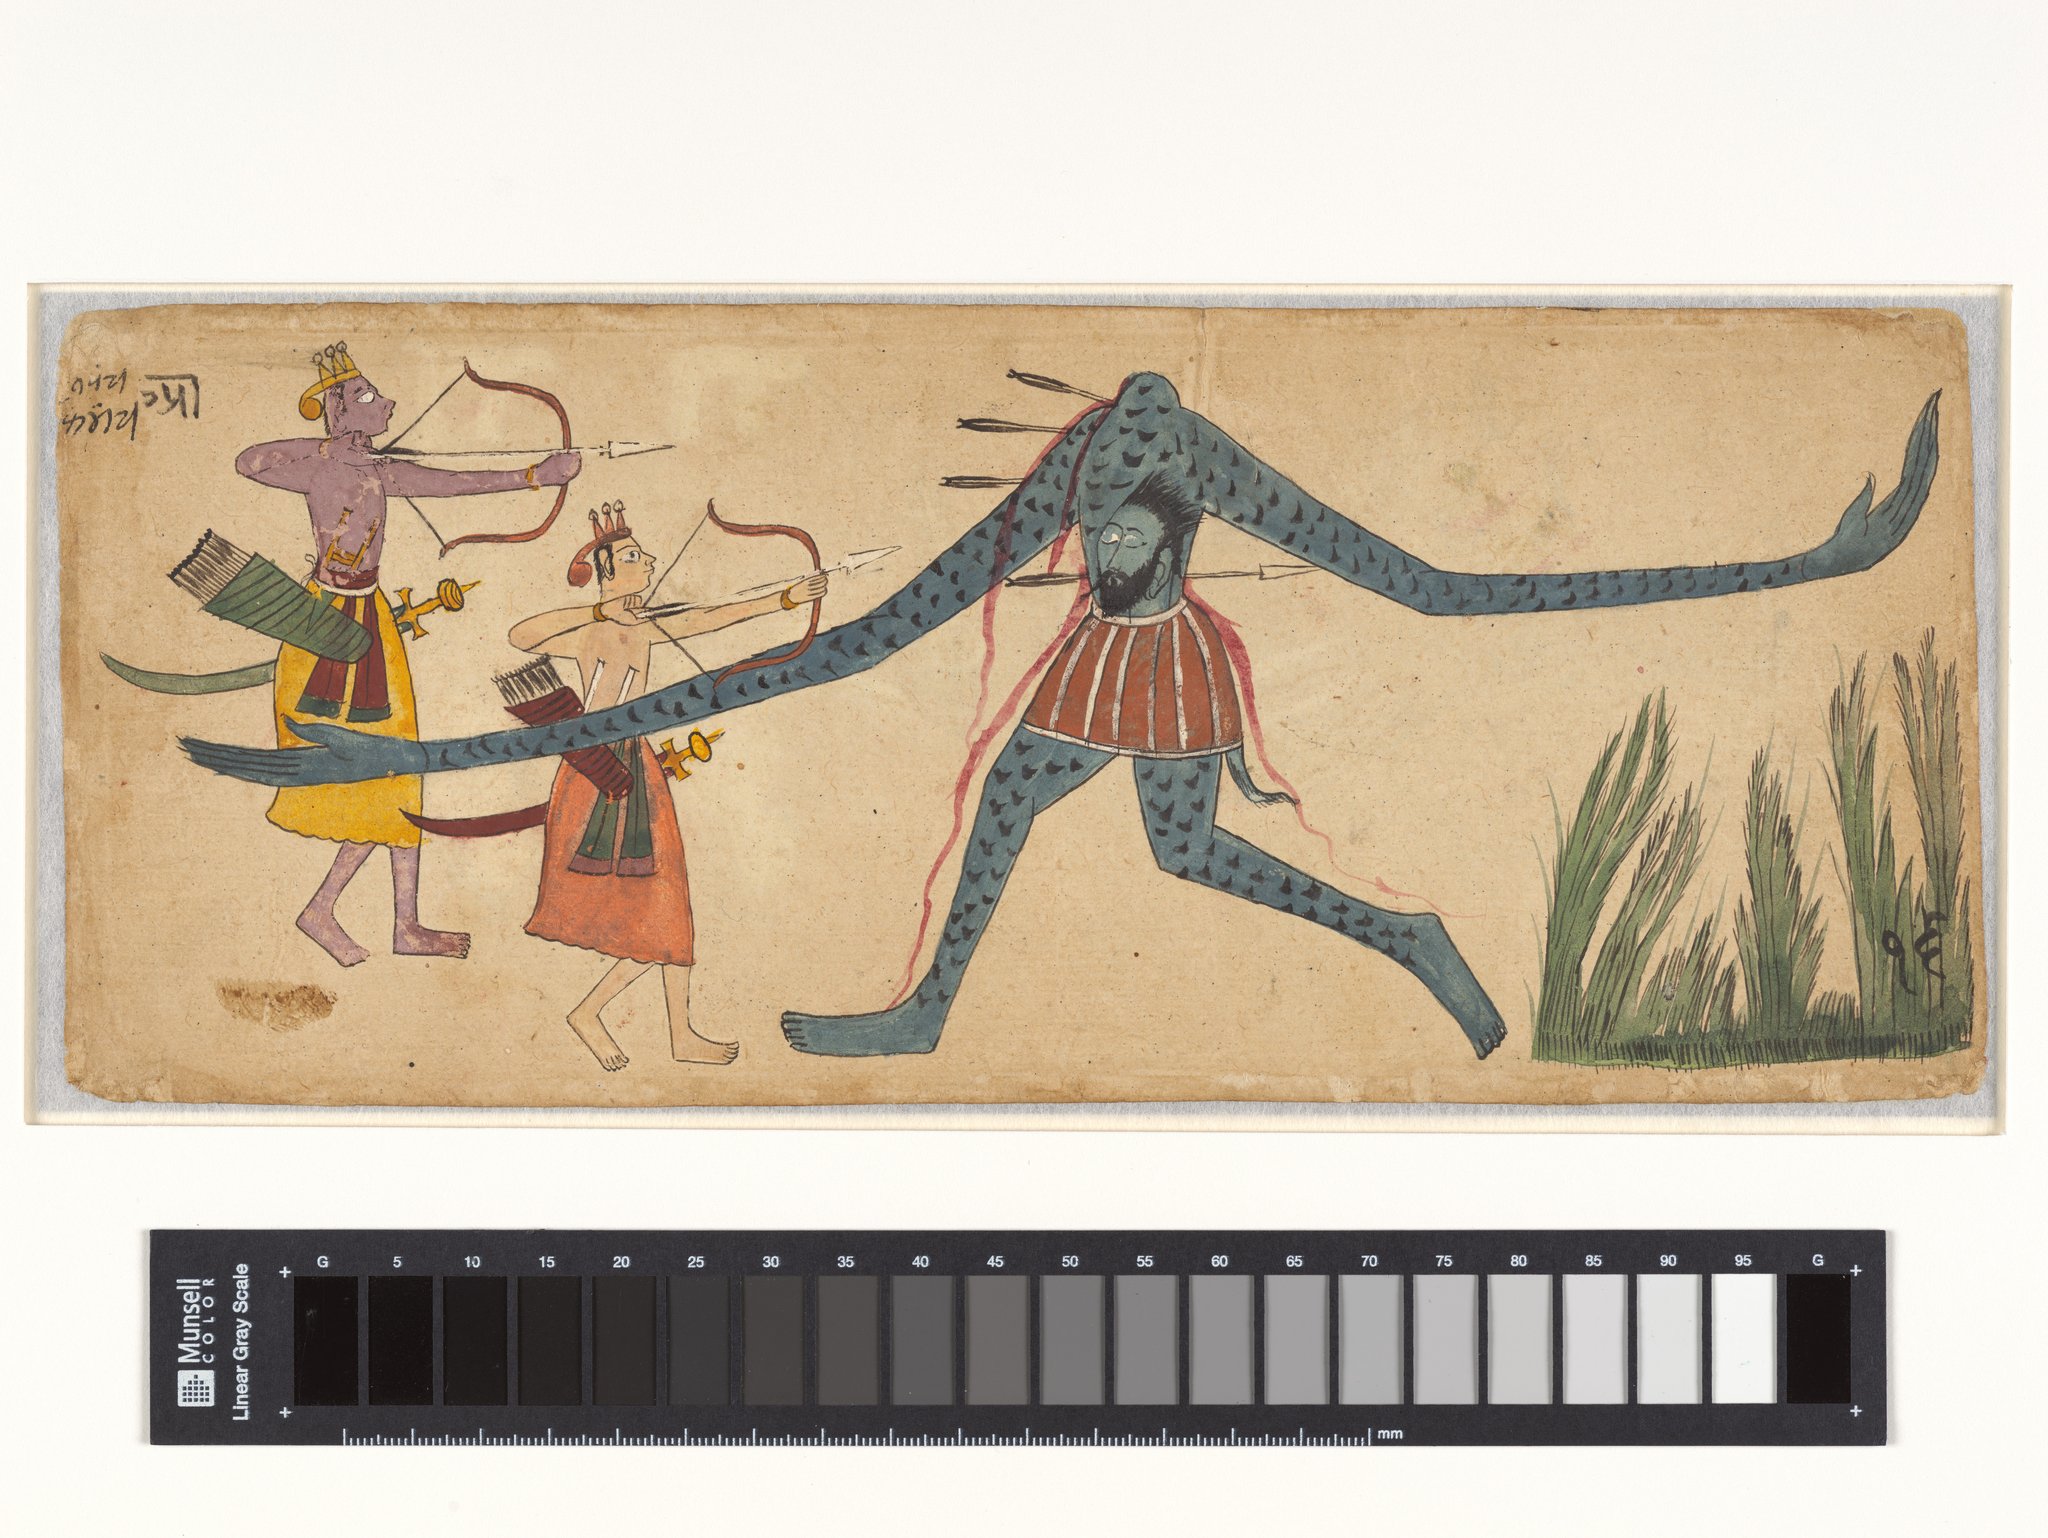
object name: folio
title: Double-sided folio from a Ramayana series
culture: india, himachal pradesh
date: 1690-1710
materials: paper, watercolor